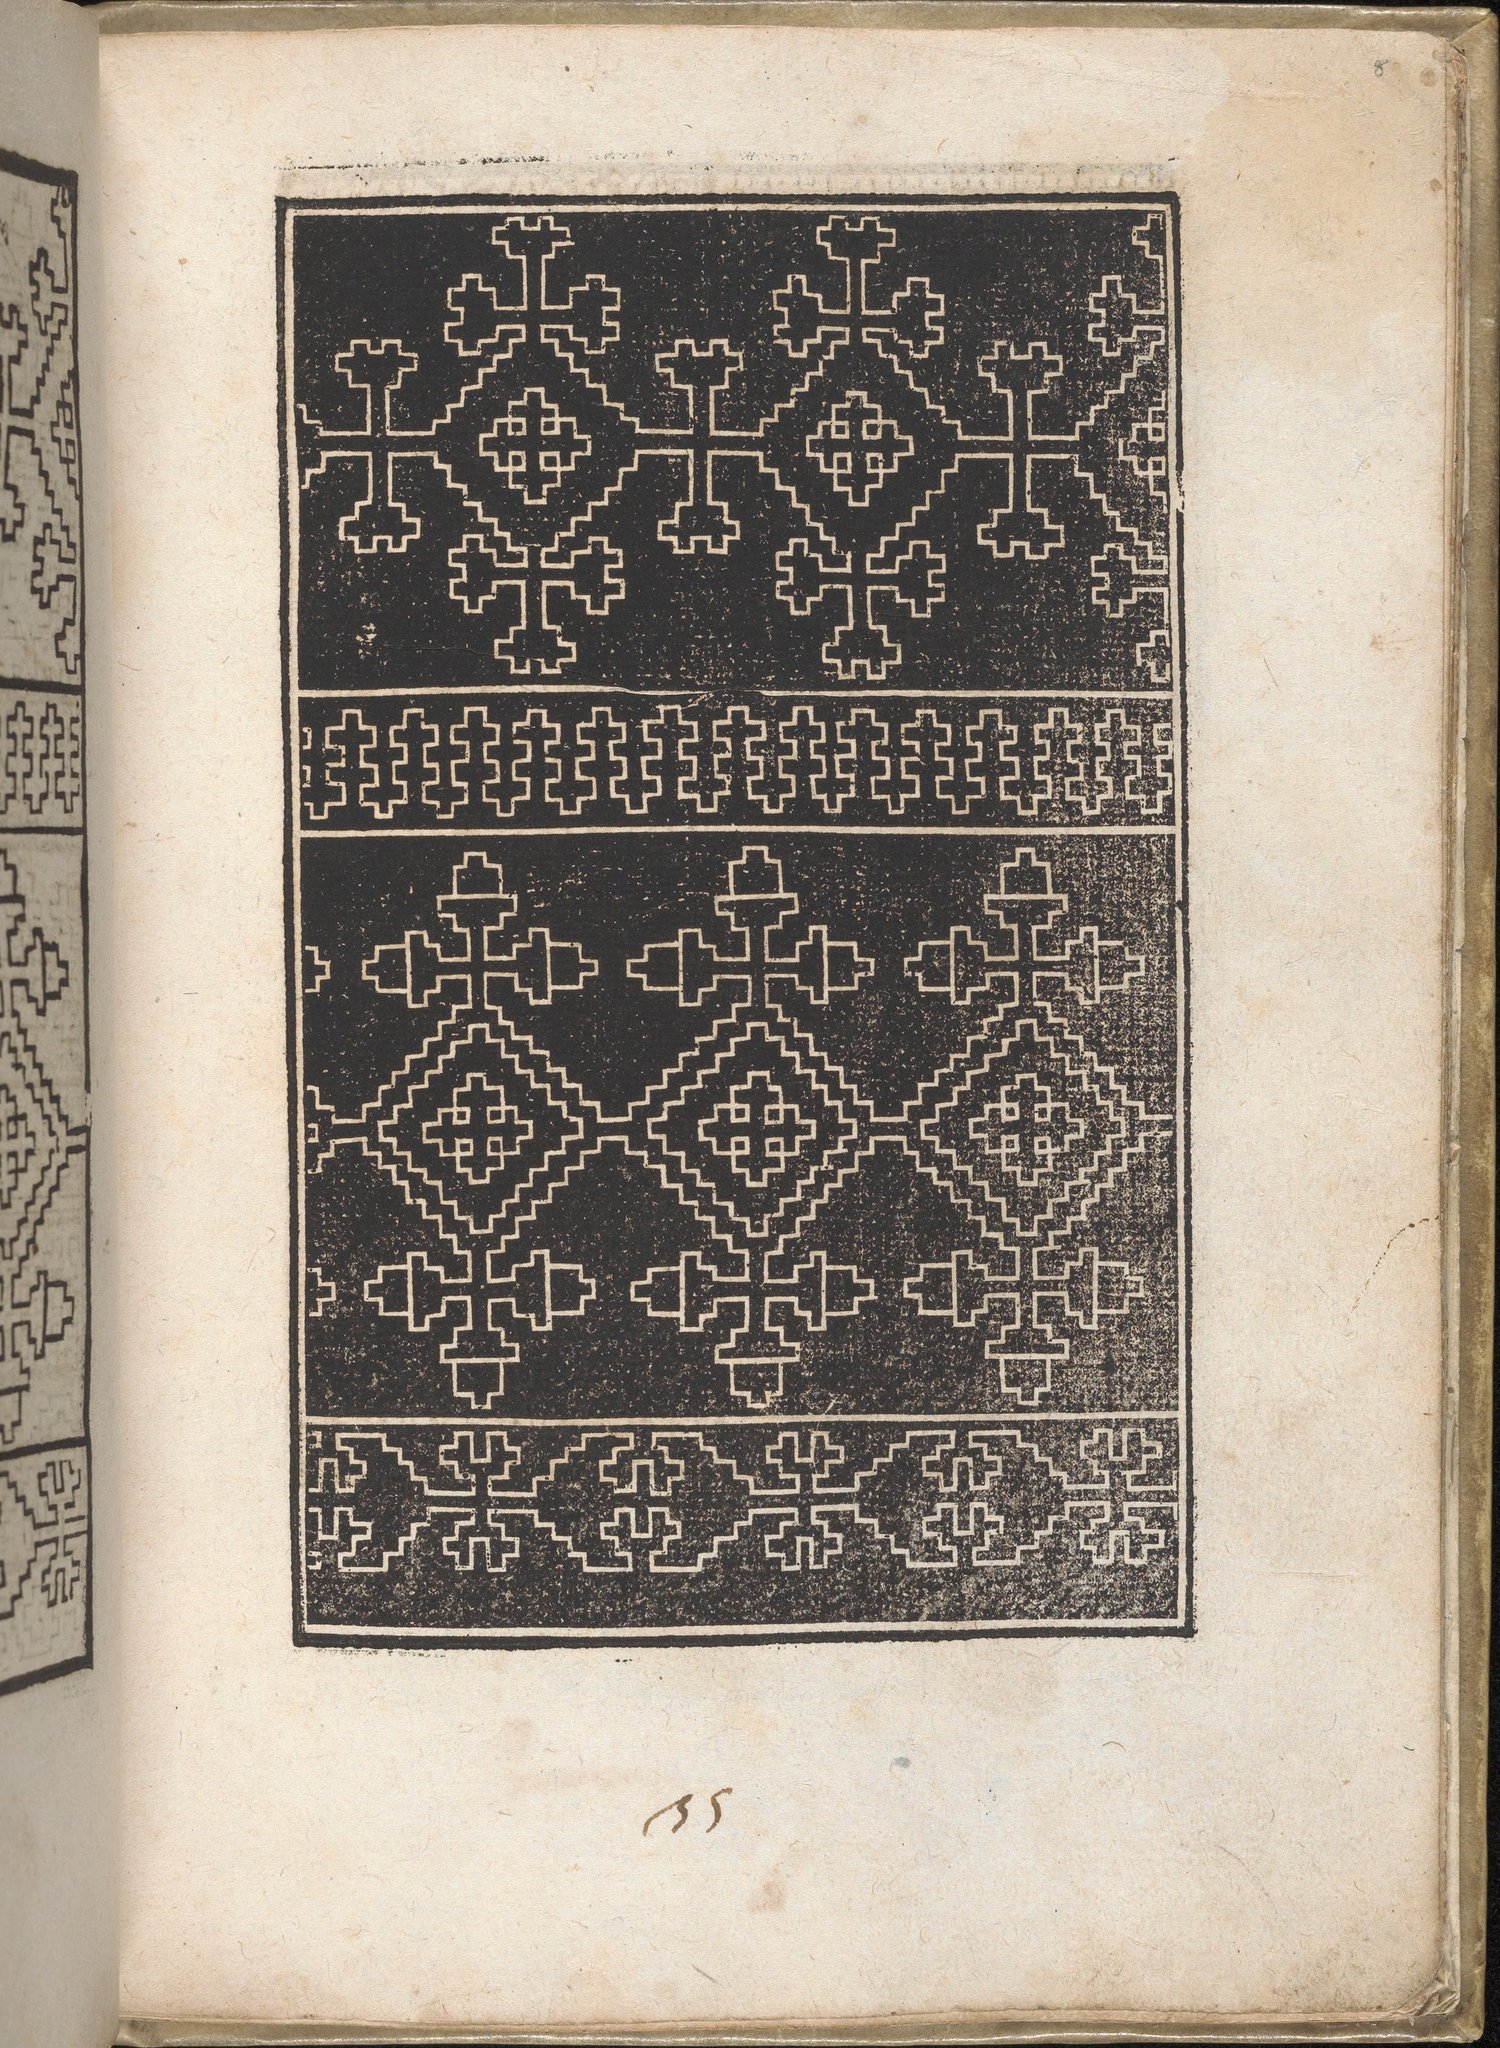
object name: book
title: Page 8v, from "Eyn New Kunstlichboich"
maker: peter quentel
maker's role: publisher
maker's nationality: german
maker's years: 1500-1550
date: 1529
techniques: woodcut